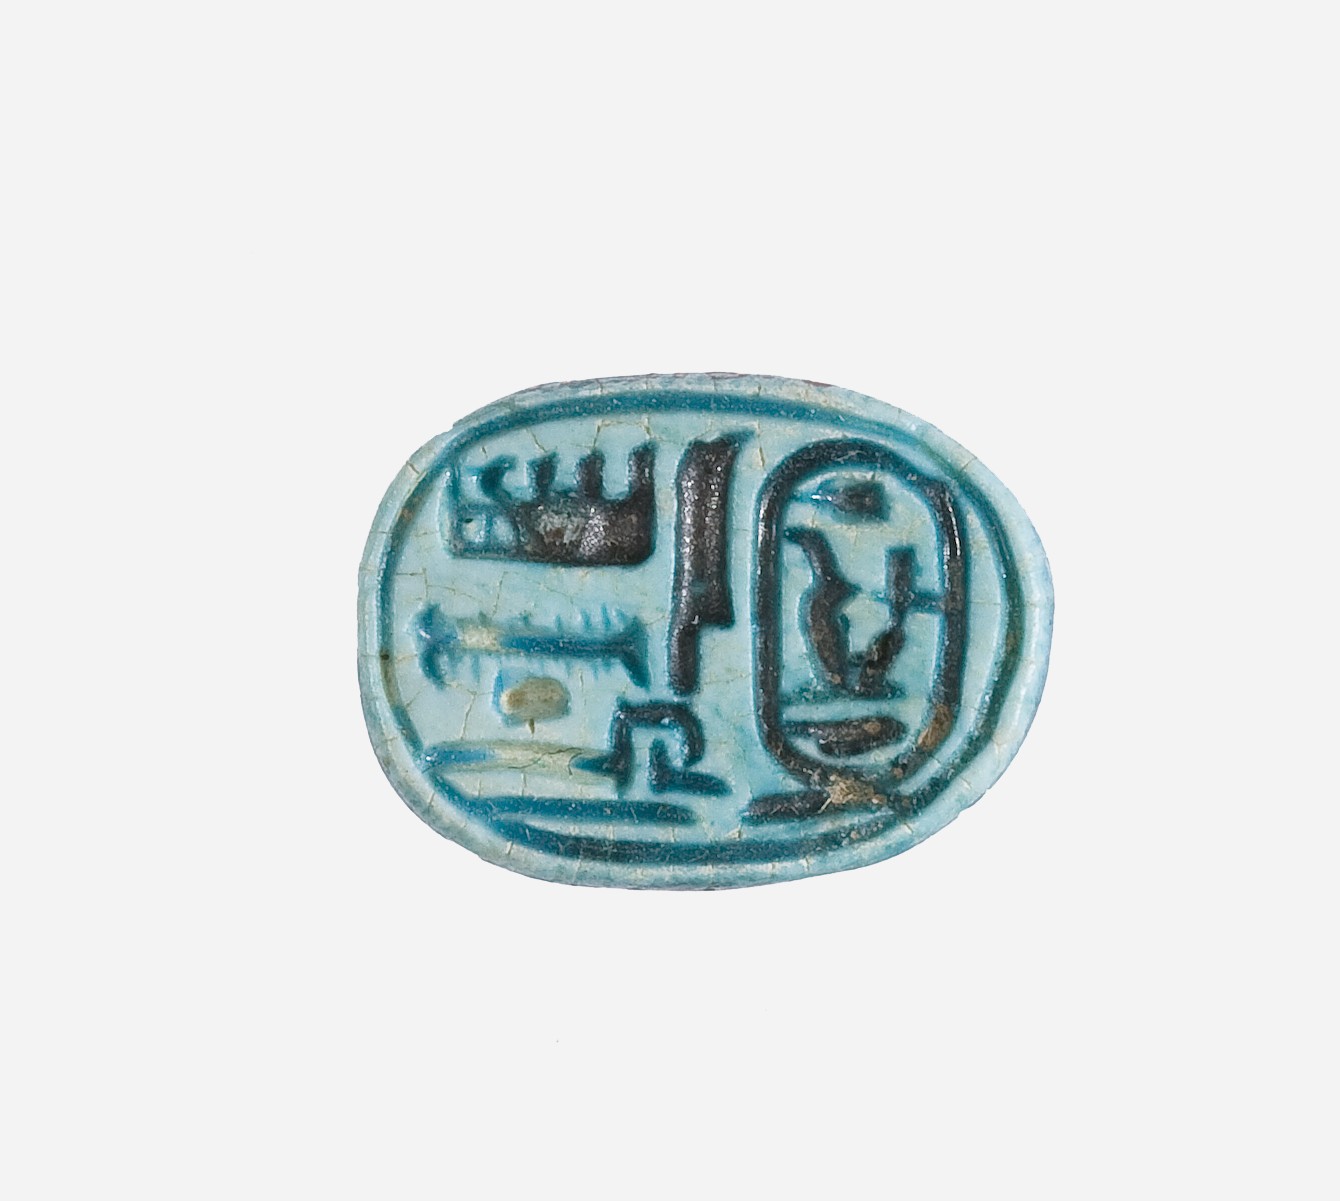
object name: scarab, amenhotep iii, nebmaatre, amun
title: Scarab Inscribed for Amenhotep III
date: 1390-1352 BCE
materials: mica, stone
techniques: glazing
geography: egypt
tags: hieroglyphs,scarabs